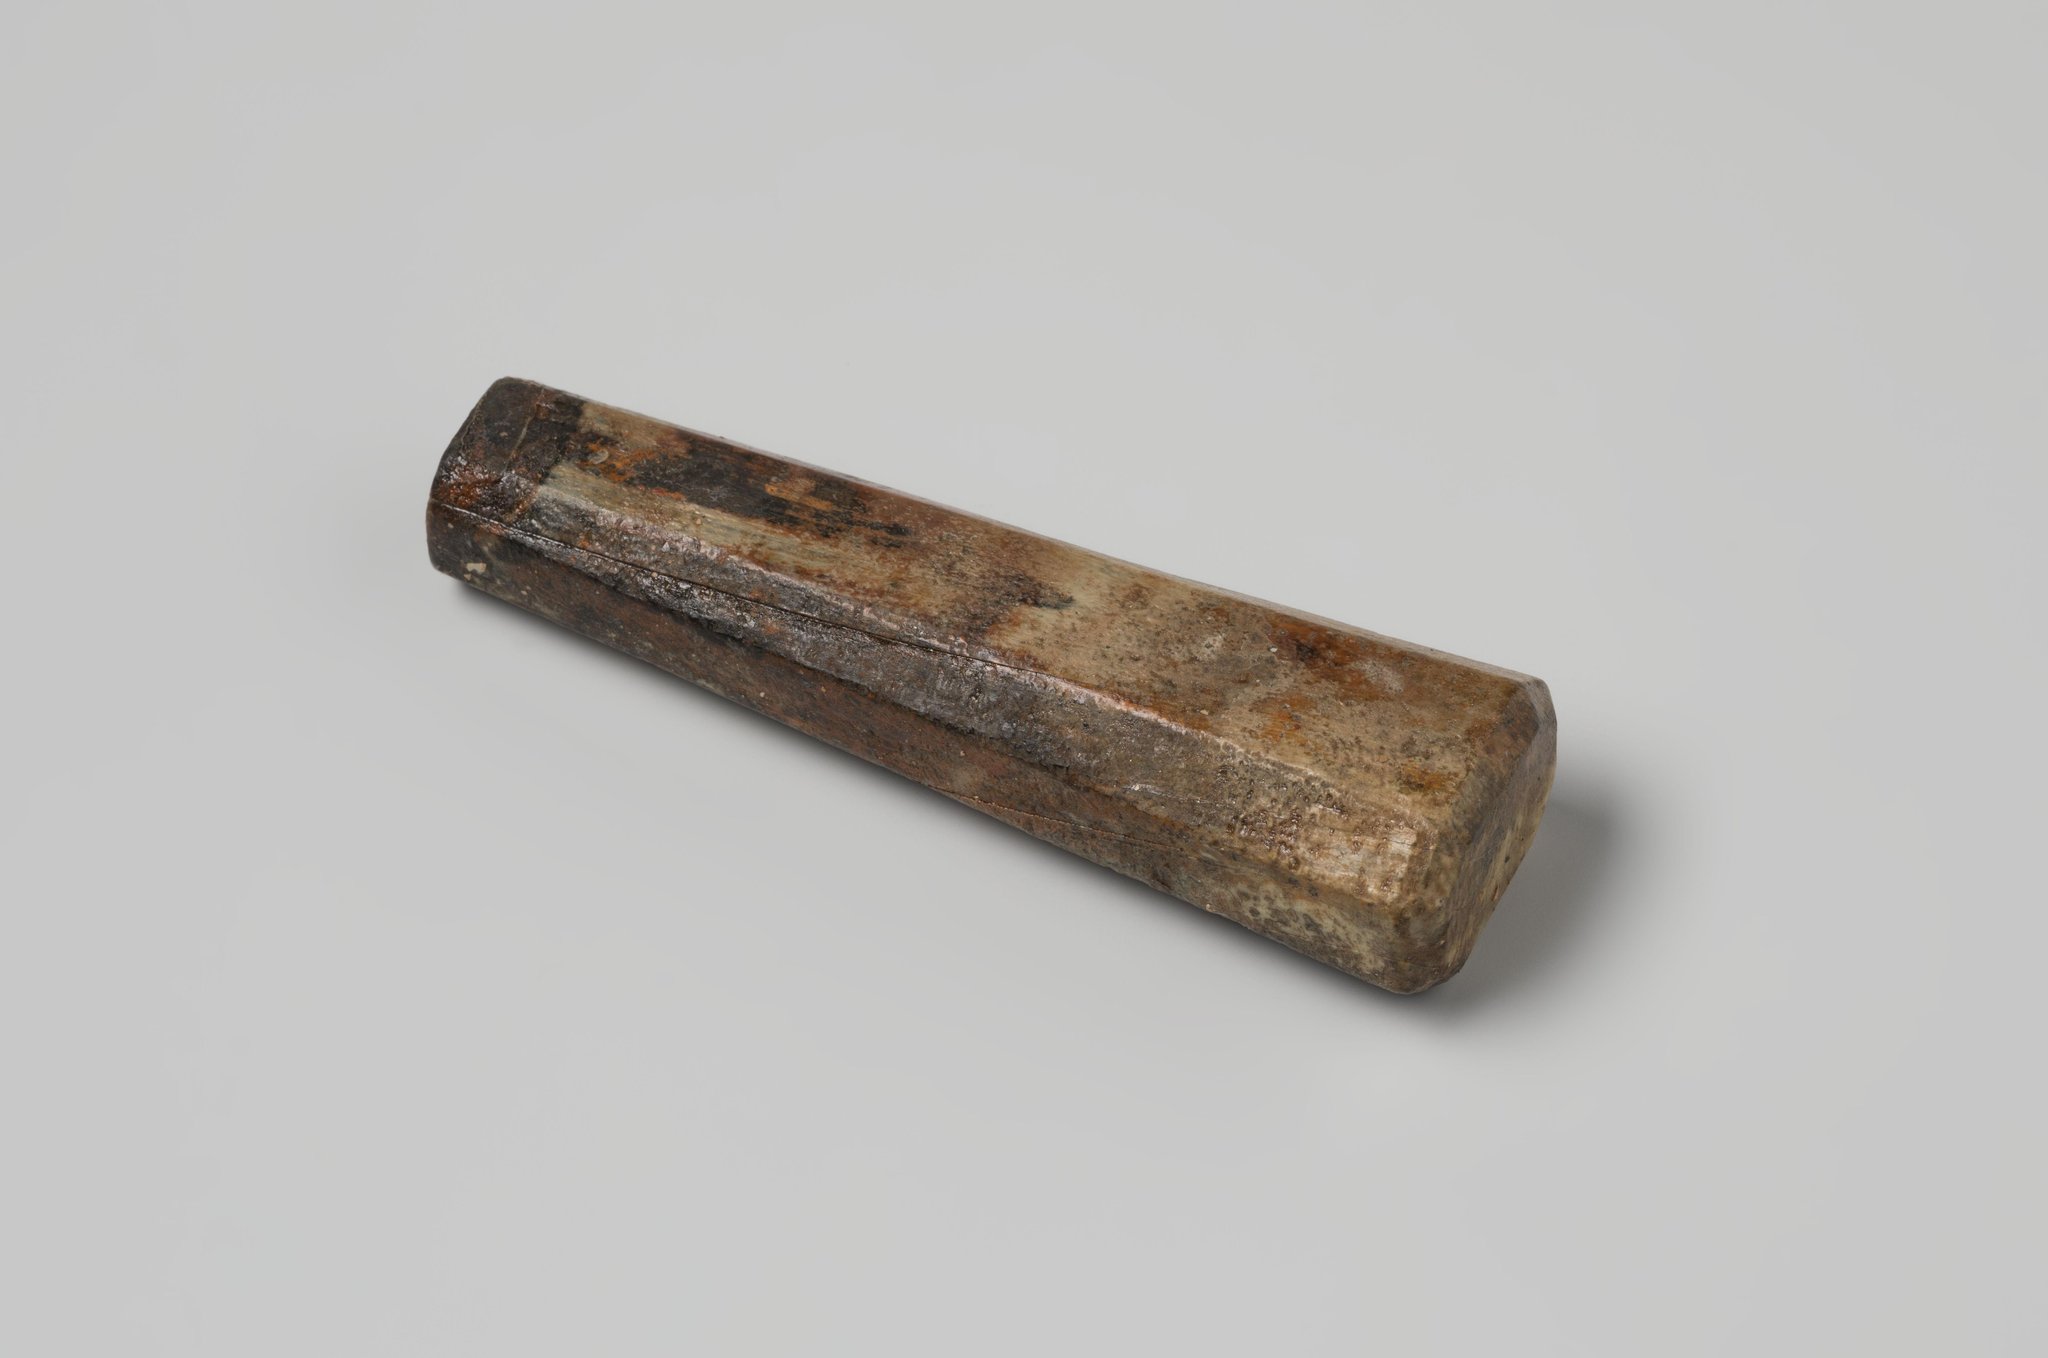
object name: knife handle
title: Messenheft uit het wrak van de Oost-Indiëvaarder Hollandia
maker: Anonymous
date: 1700-1743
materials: bone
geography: netherlands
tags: verenigde oostindische compagnie, hollandia (schip), annet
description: Knife-handle, straight-sided: tapering; hexagonal faceted, straight ends.